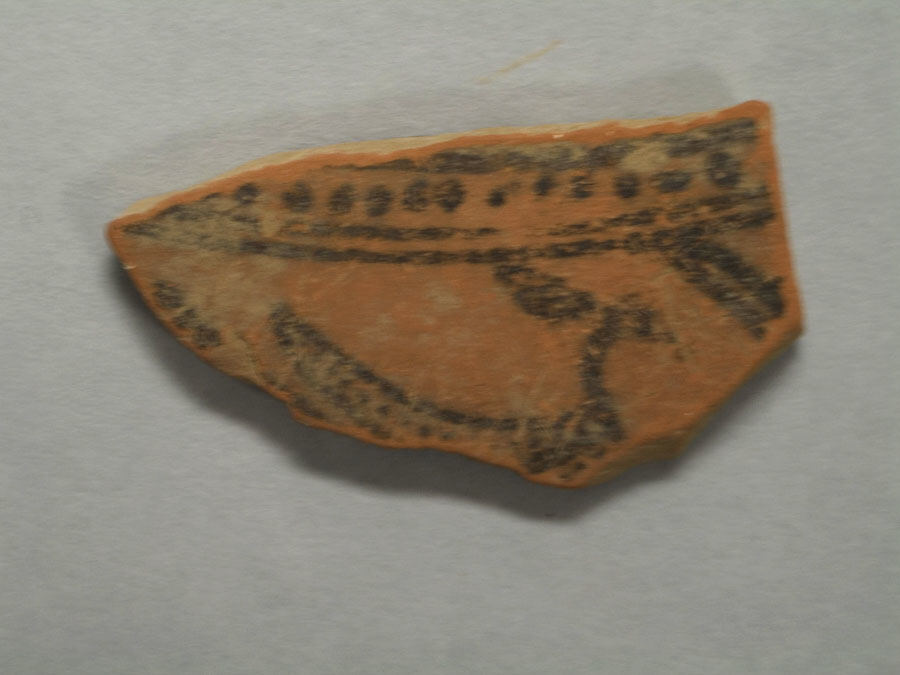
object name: shard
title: Shard: Bird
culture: pakistani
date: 301-500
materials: terracotta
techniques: painting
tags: birds,gandhara